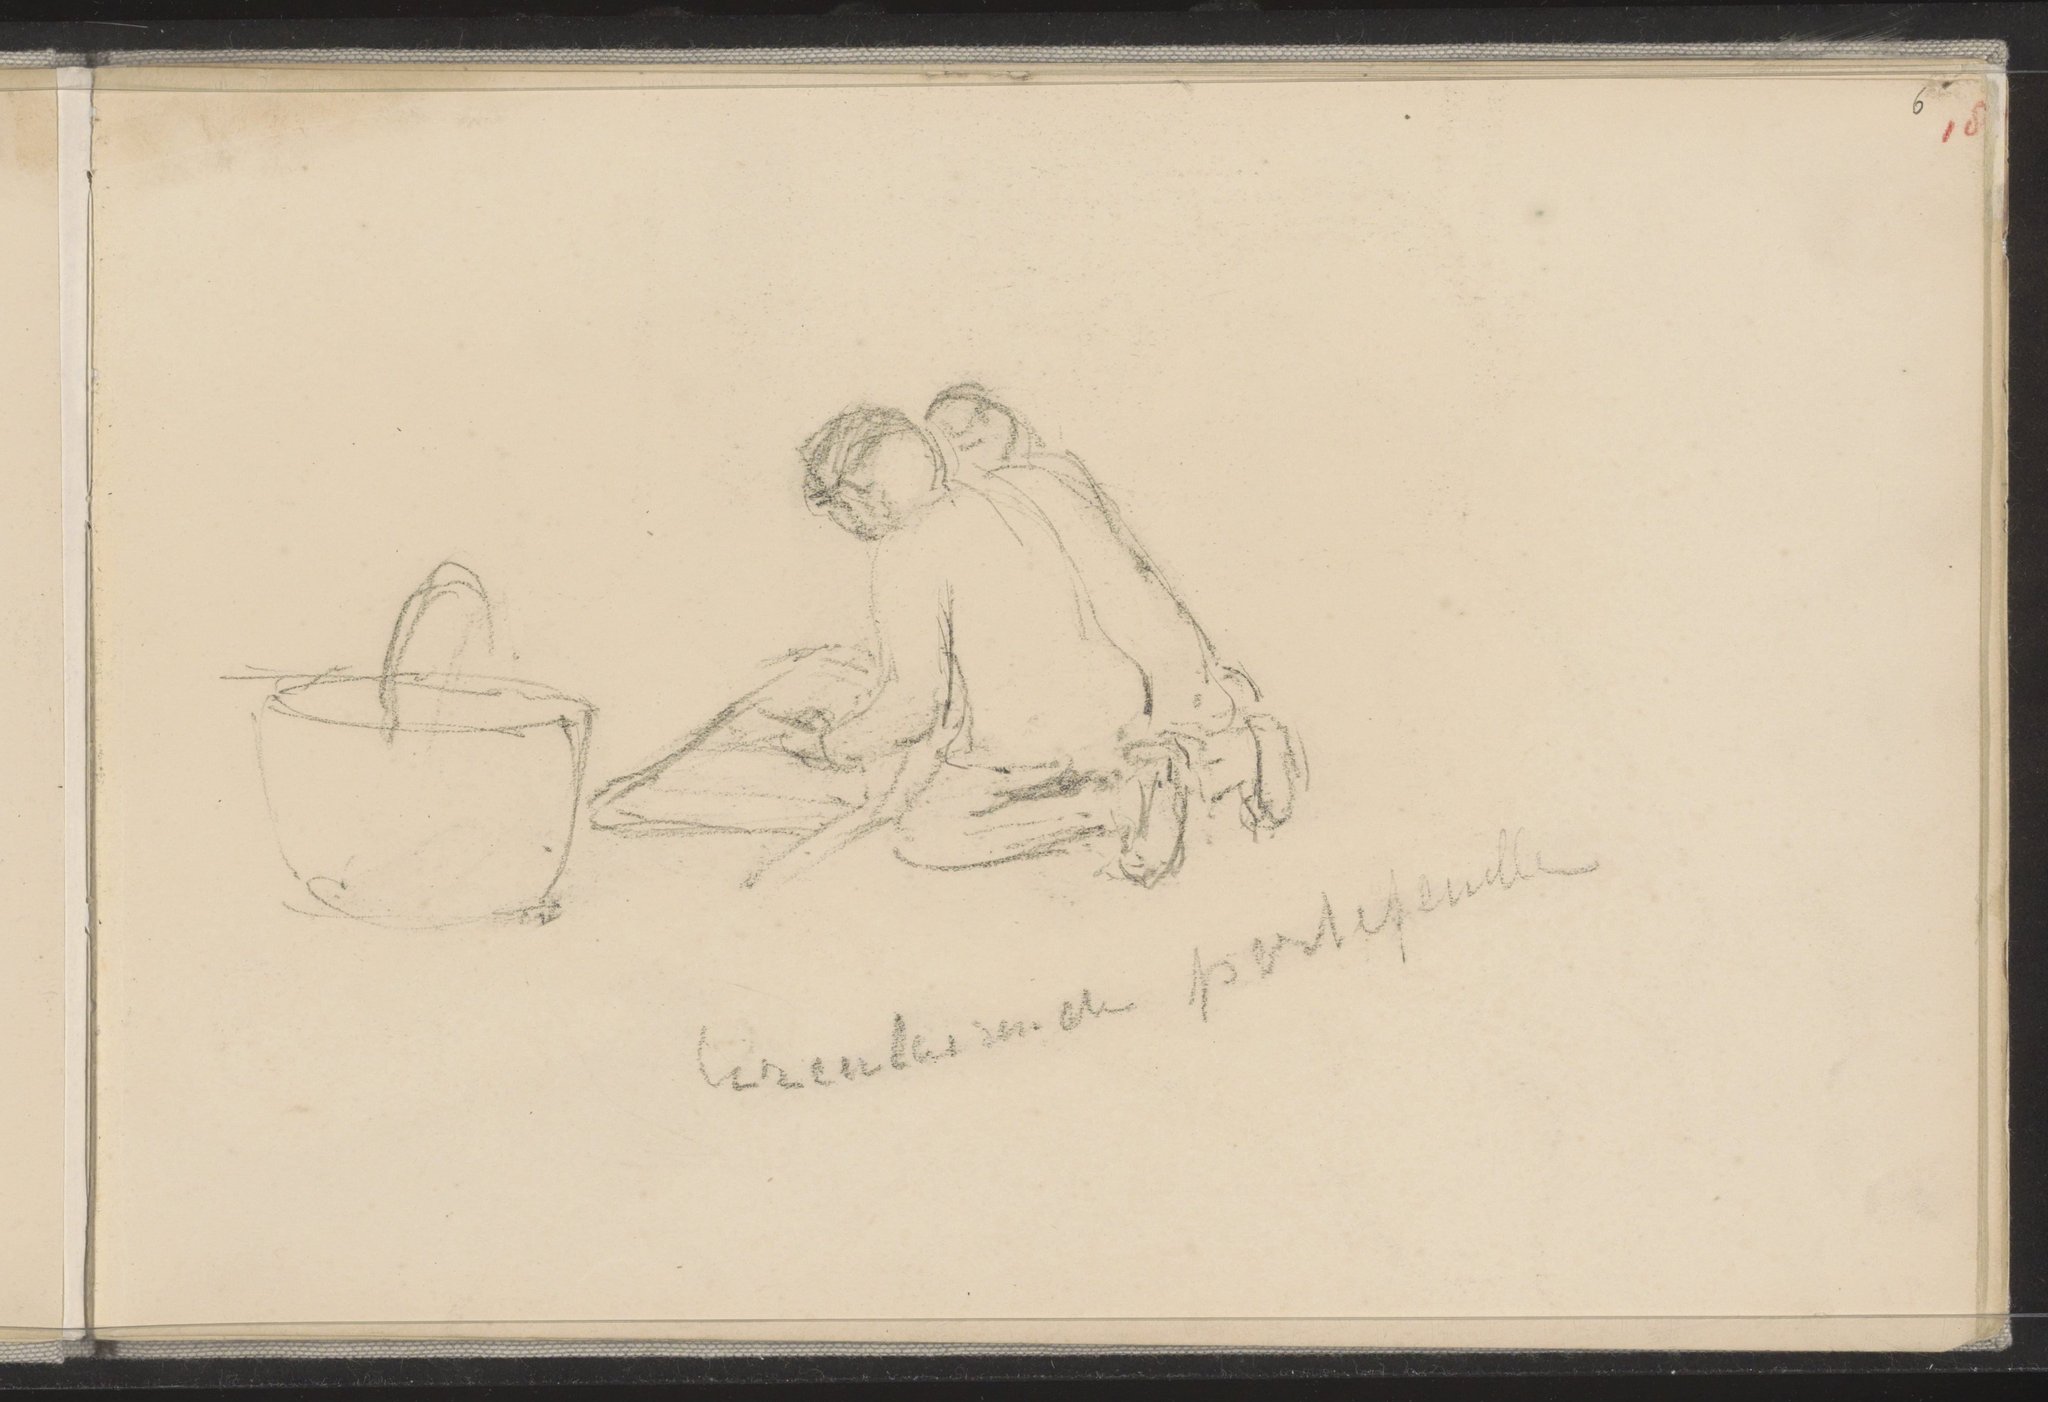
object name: sketchbook leaf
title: Twee knielende kinderen naast een man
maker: jozef israëls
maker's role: draughtsman, painter, print maker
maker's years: 1824-1911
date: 1834-1911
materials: chalk, paper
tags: kneeling figure (+ two persons), container made of plant material other than wood: basket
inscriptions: annotation: ‘[...]renlassen.de portefeuille’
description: Blad 6 recto uit een schetsboek met 30 bladen.